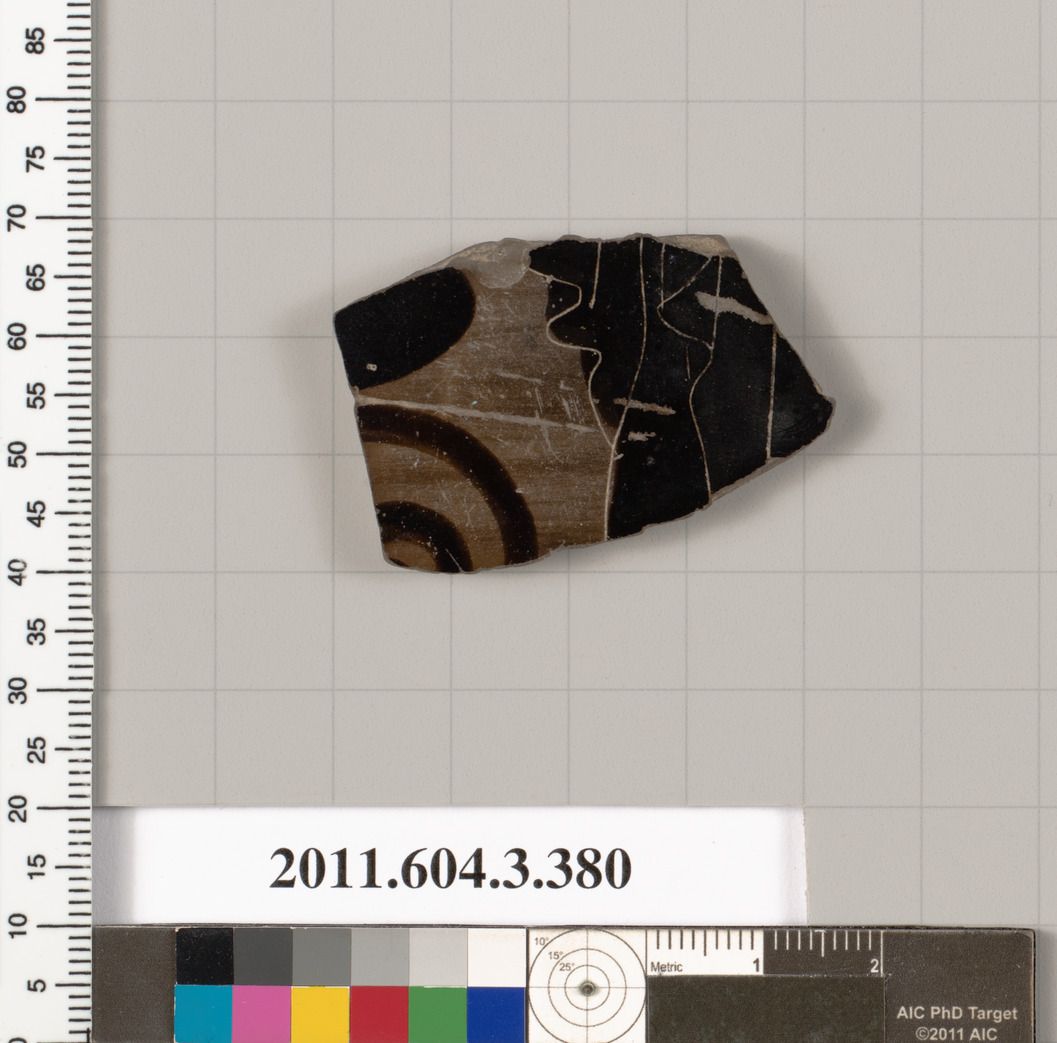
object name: neck amphora fragment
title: Terracotta fragment of a neck-amphora (jar)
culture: greek, attic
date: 534-501 BCE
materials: terracotta